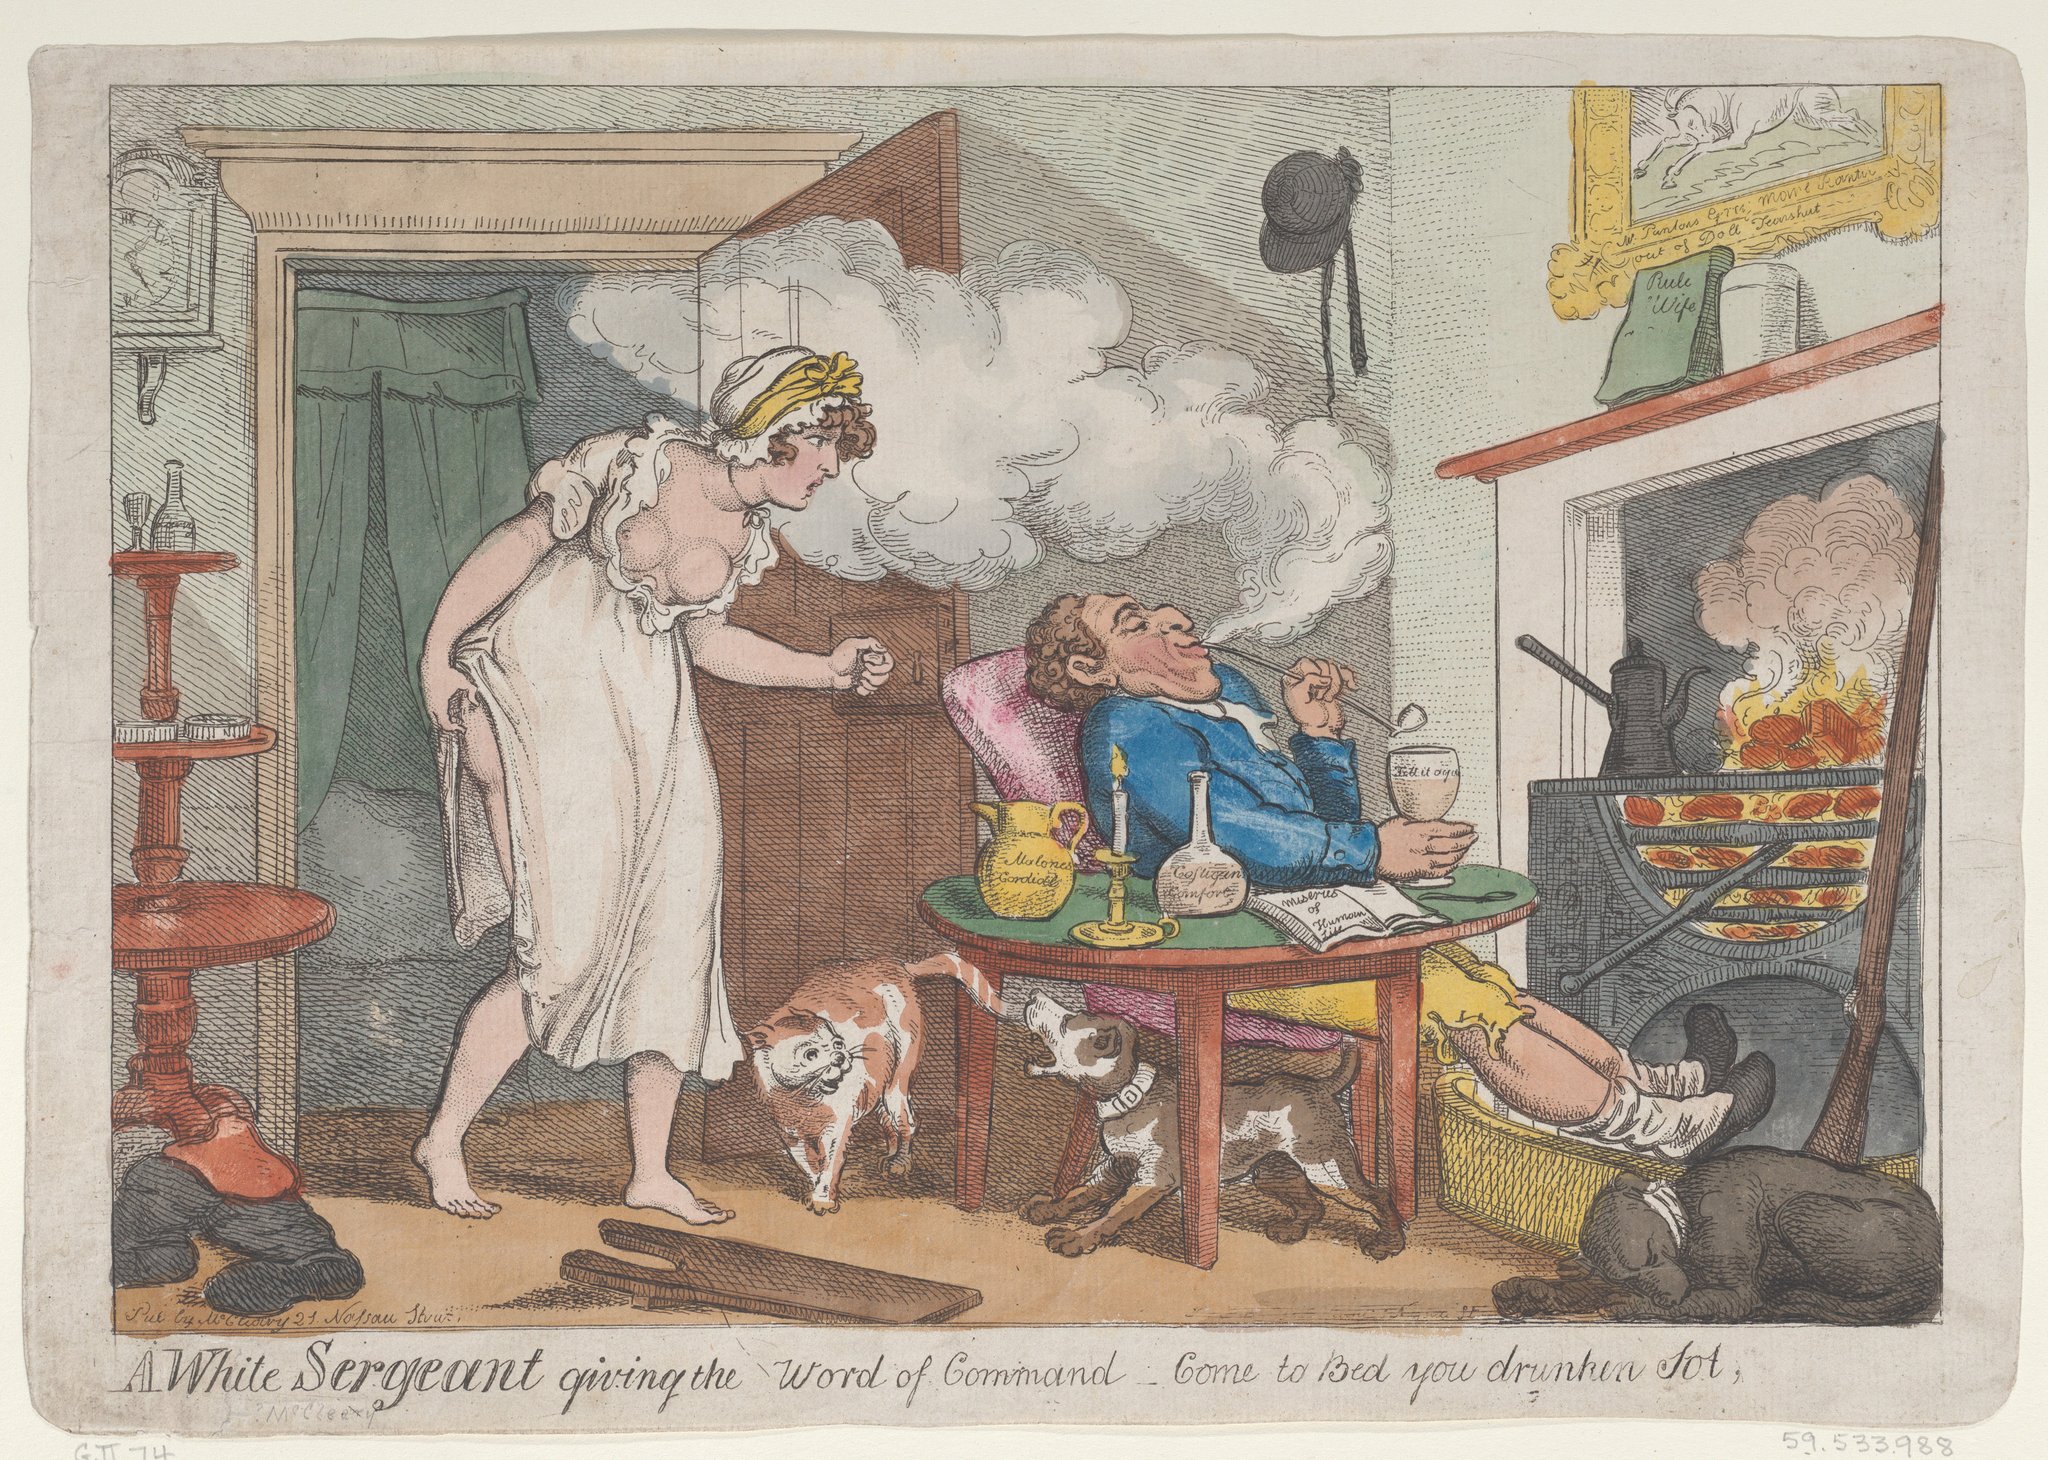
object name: print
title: A White Sergeant giving the word of command - "Come to Bed you drunken sot"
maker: thomas rowlandson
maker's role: artist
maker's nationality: british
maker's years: 1757-1827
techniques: etching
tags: satire,men,women,smoking,cats,dogs